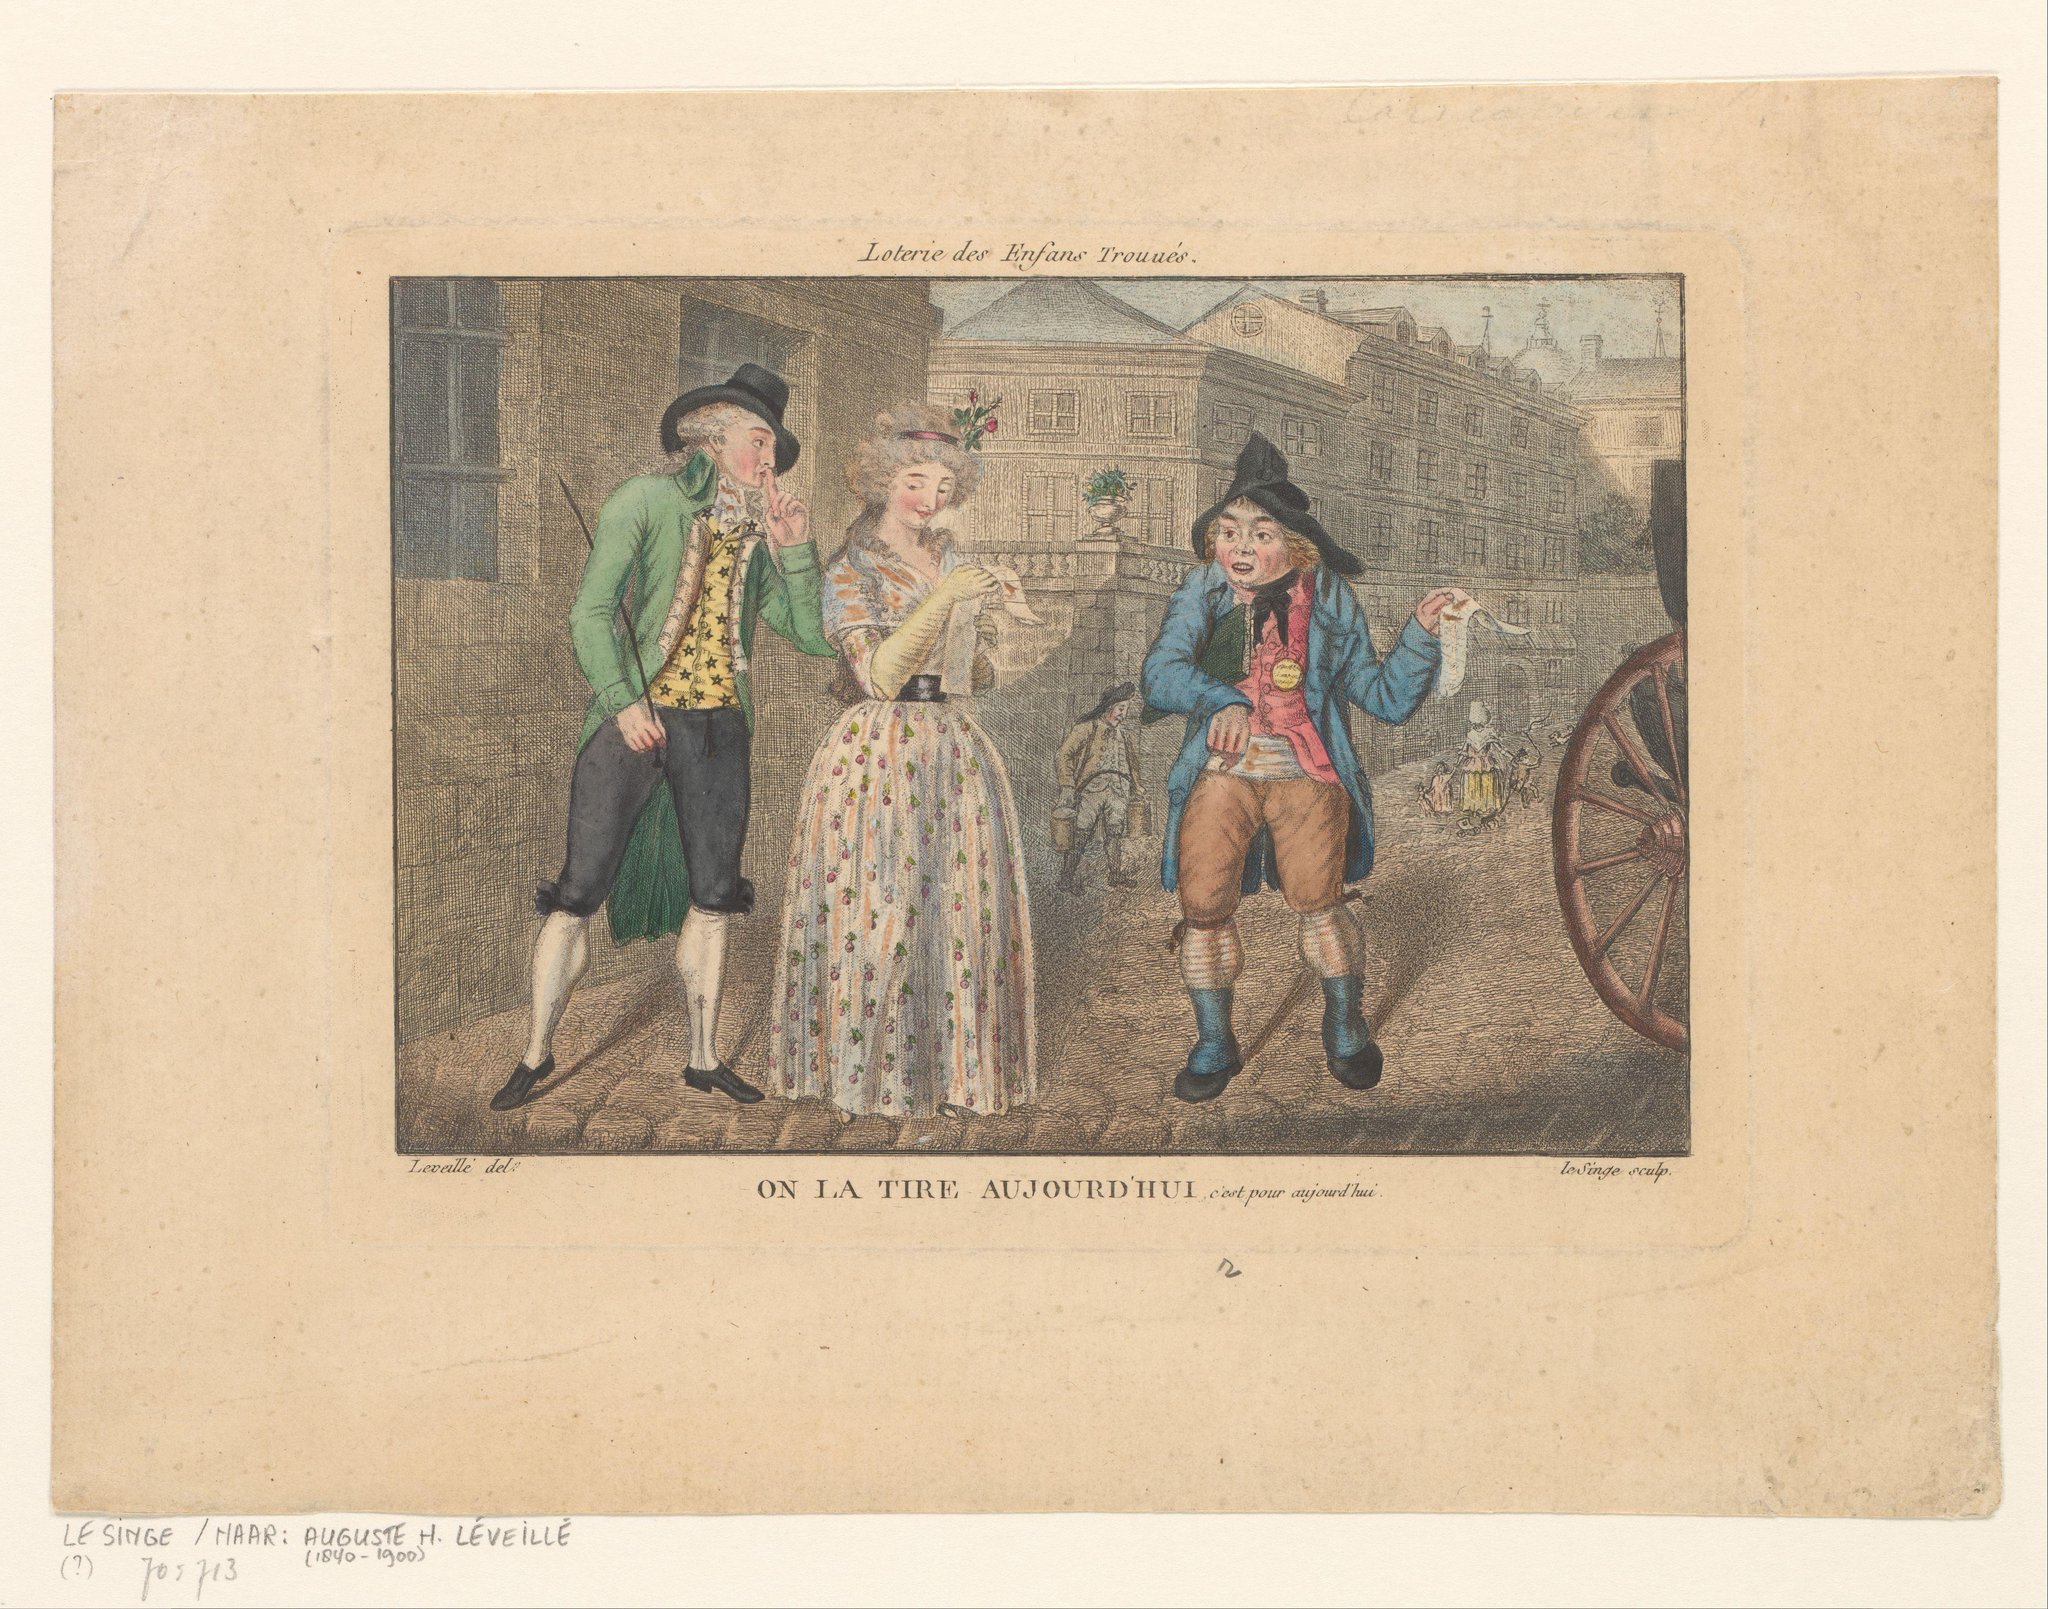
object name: cartoon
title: On la tire aujourd'hui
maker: le singe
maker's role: print maker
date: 1800-1899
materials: paper, watercolor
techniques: etching, hand coloring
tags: raffle, lottery, foundling (and adoption), street-trader, selling, public road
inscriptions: collector's mark: Lugt 2228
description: Straatscène in Parijs: een straatverkoper verkoopt loten aan een modieus gekleed stel voor de trekking van de dag van de loterij ten bate van te vondeling gelegde kinderen.